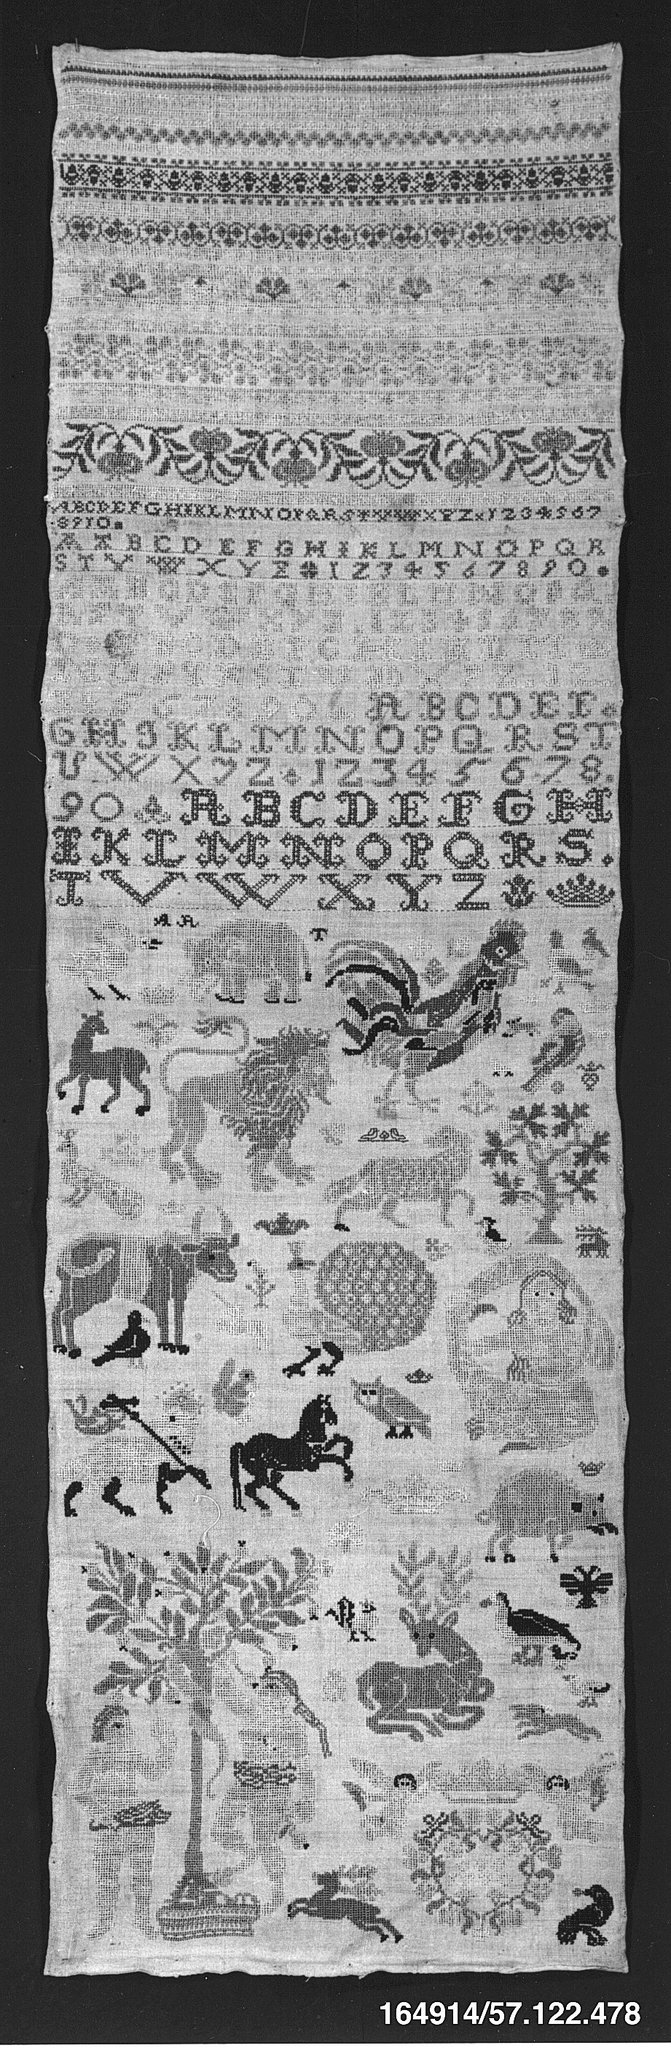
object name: sampler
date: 1770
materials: linen, silk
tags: owls,horses,lions